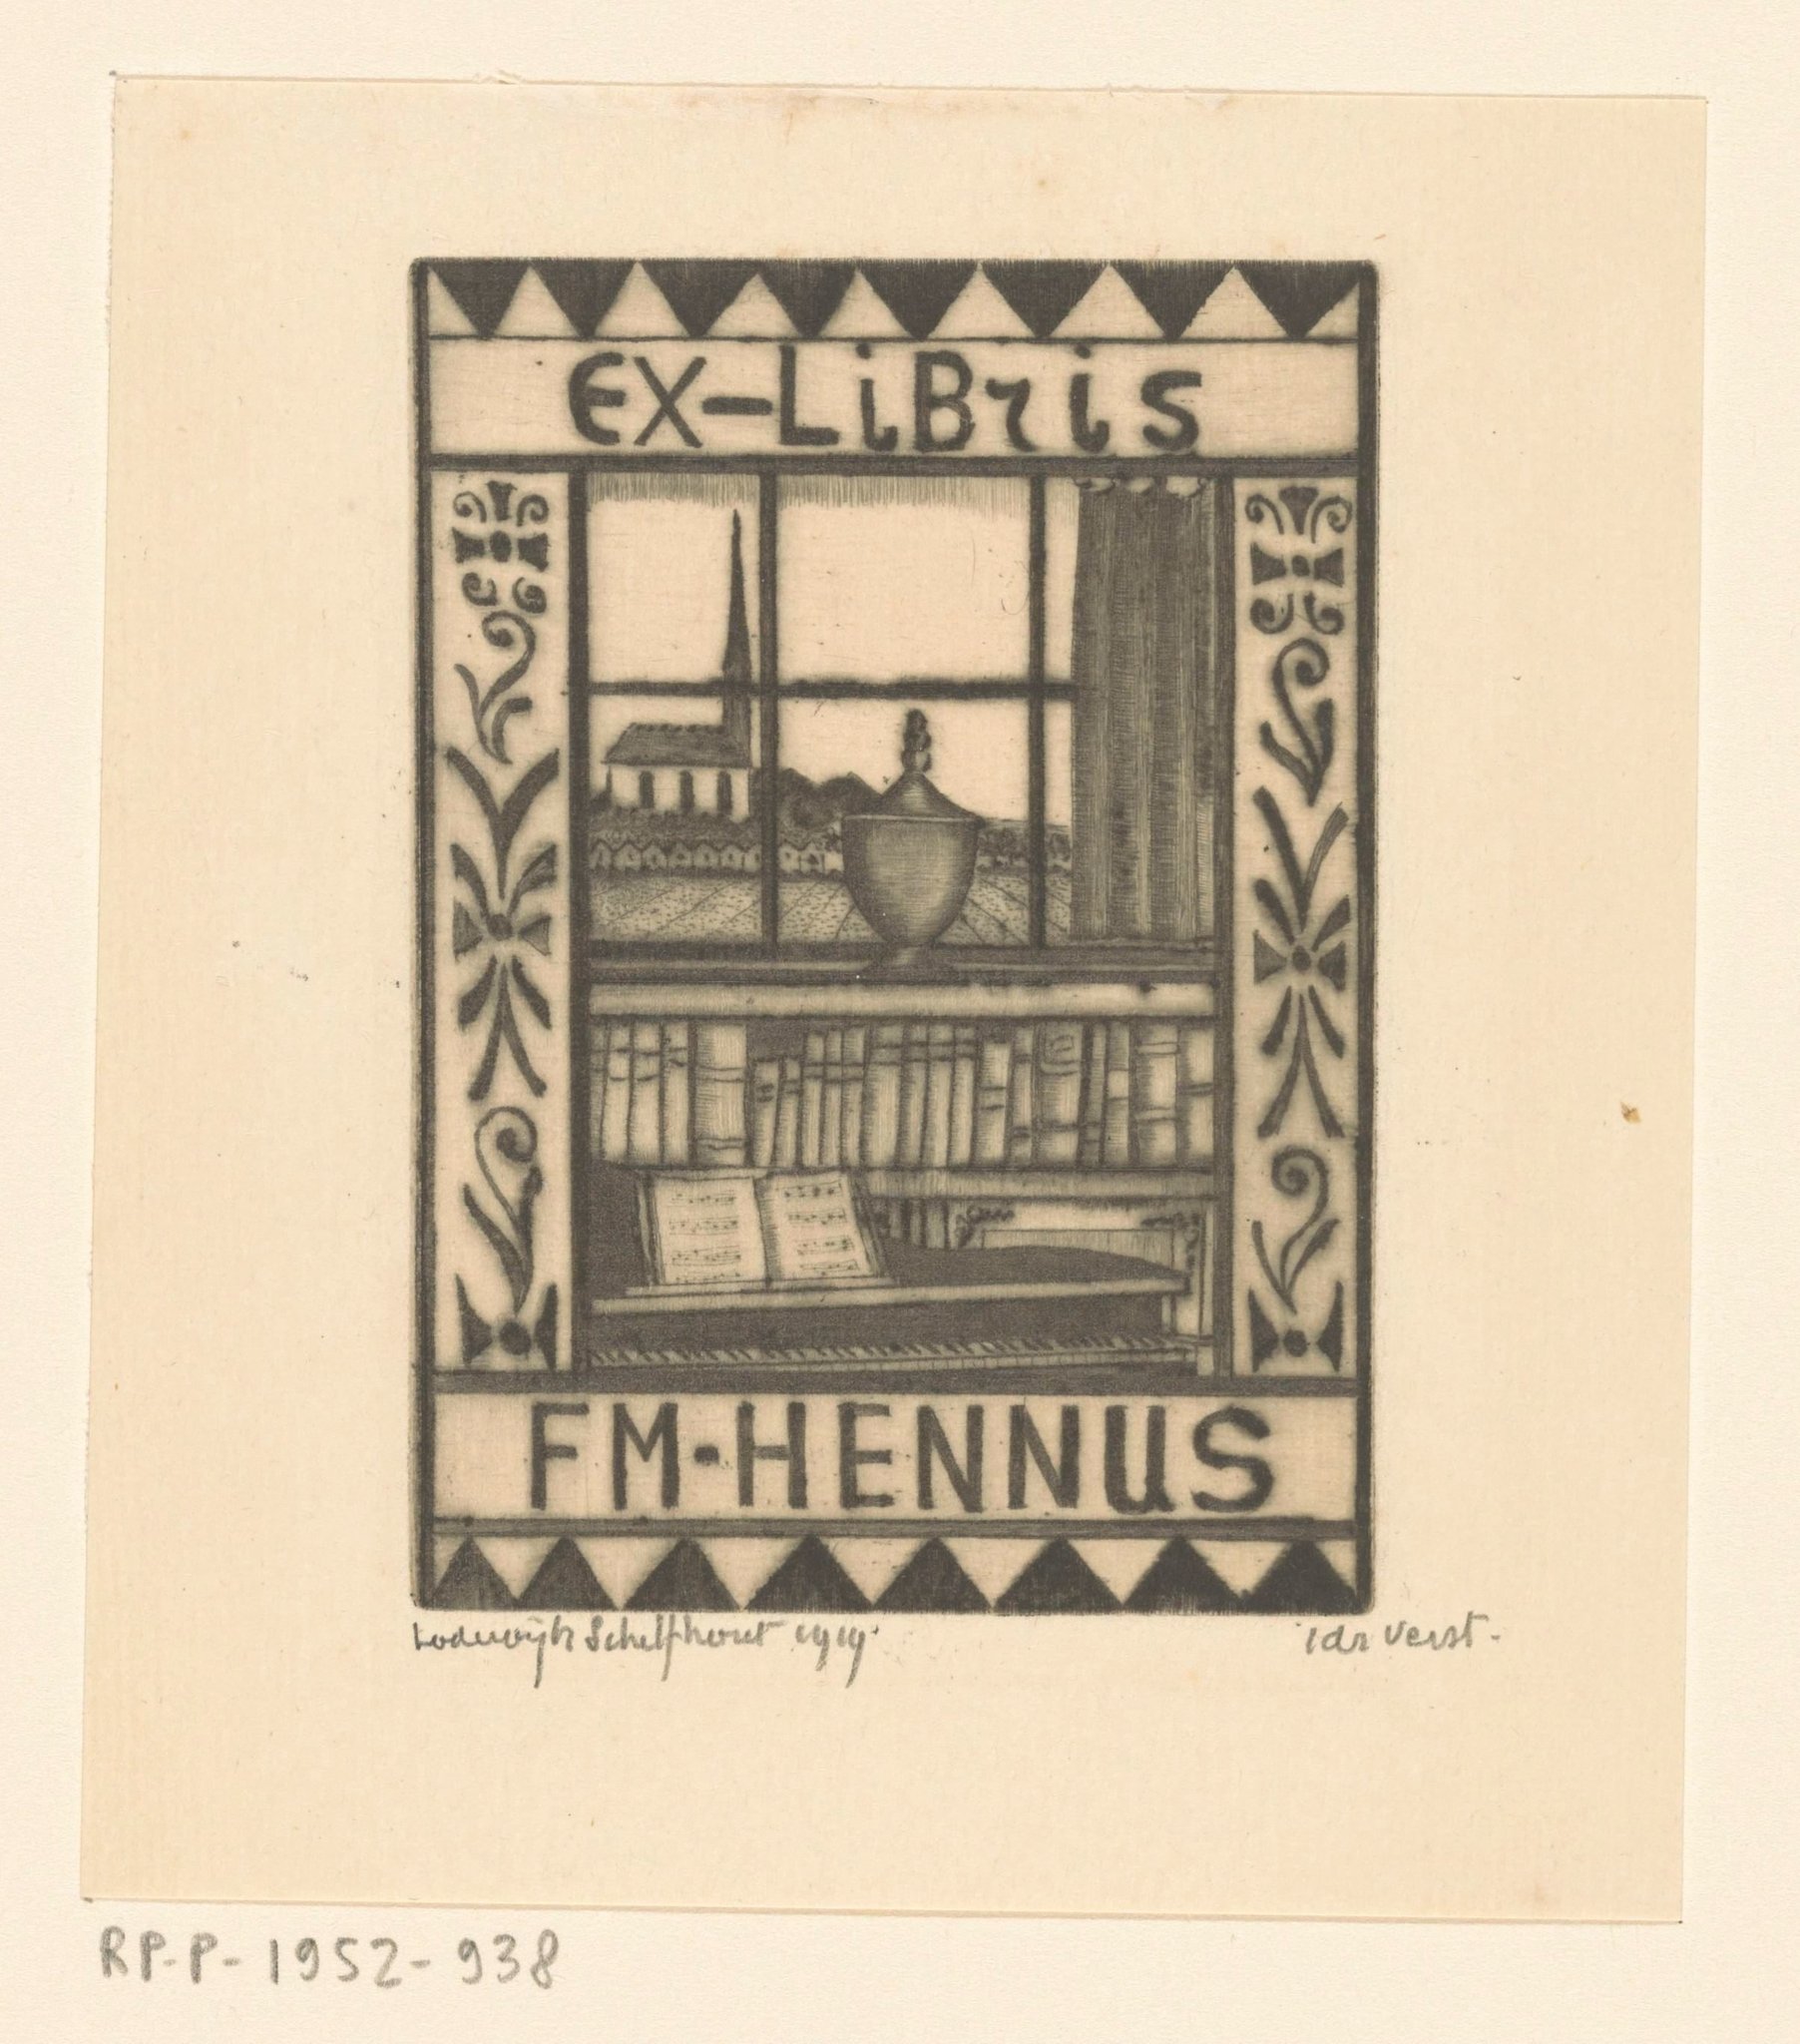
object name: bookplate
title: Ex libris van Michiel Frederik Hennus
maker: lodewijk schelfhout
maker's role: draughtsman, print maker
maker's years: 1881-1943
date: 1919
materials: paper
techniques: drypoint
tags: arnhem, michiel frederik hennus, church (exterior), view through a window from the inside, book, pianoforte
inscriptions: collector's mark: Lugt 2228, collector's mark: Lugt 2760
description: Een interieur met een piano en een boekenplank. Door een venster zicht op een kerk.